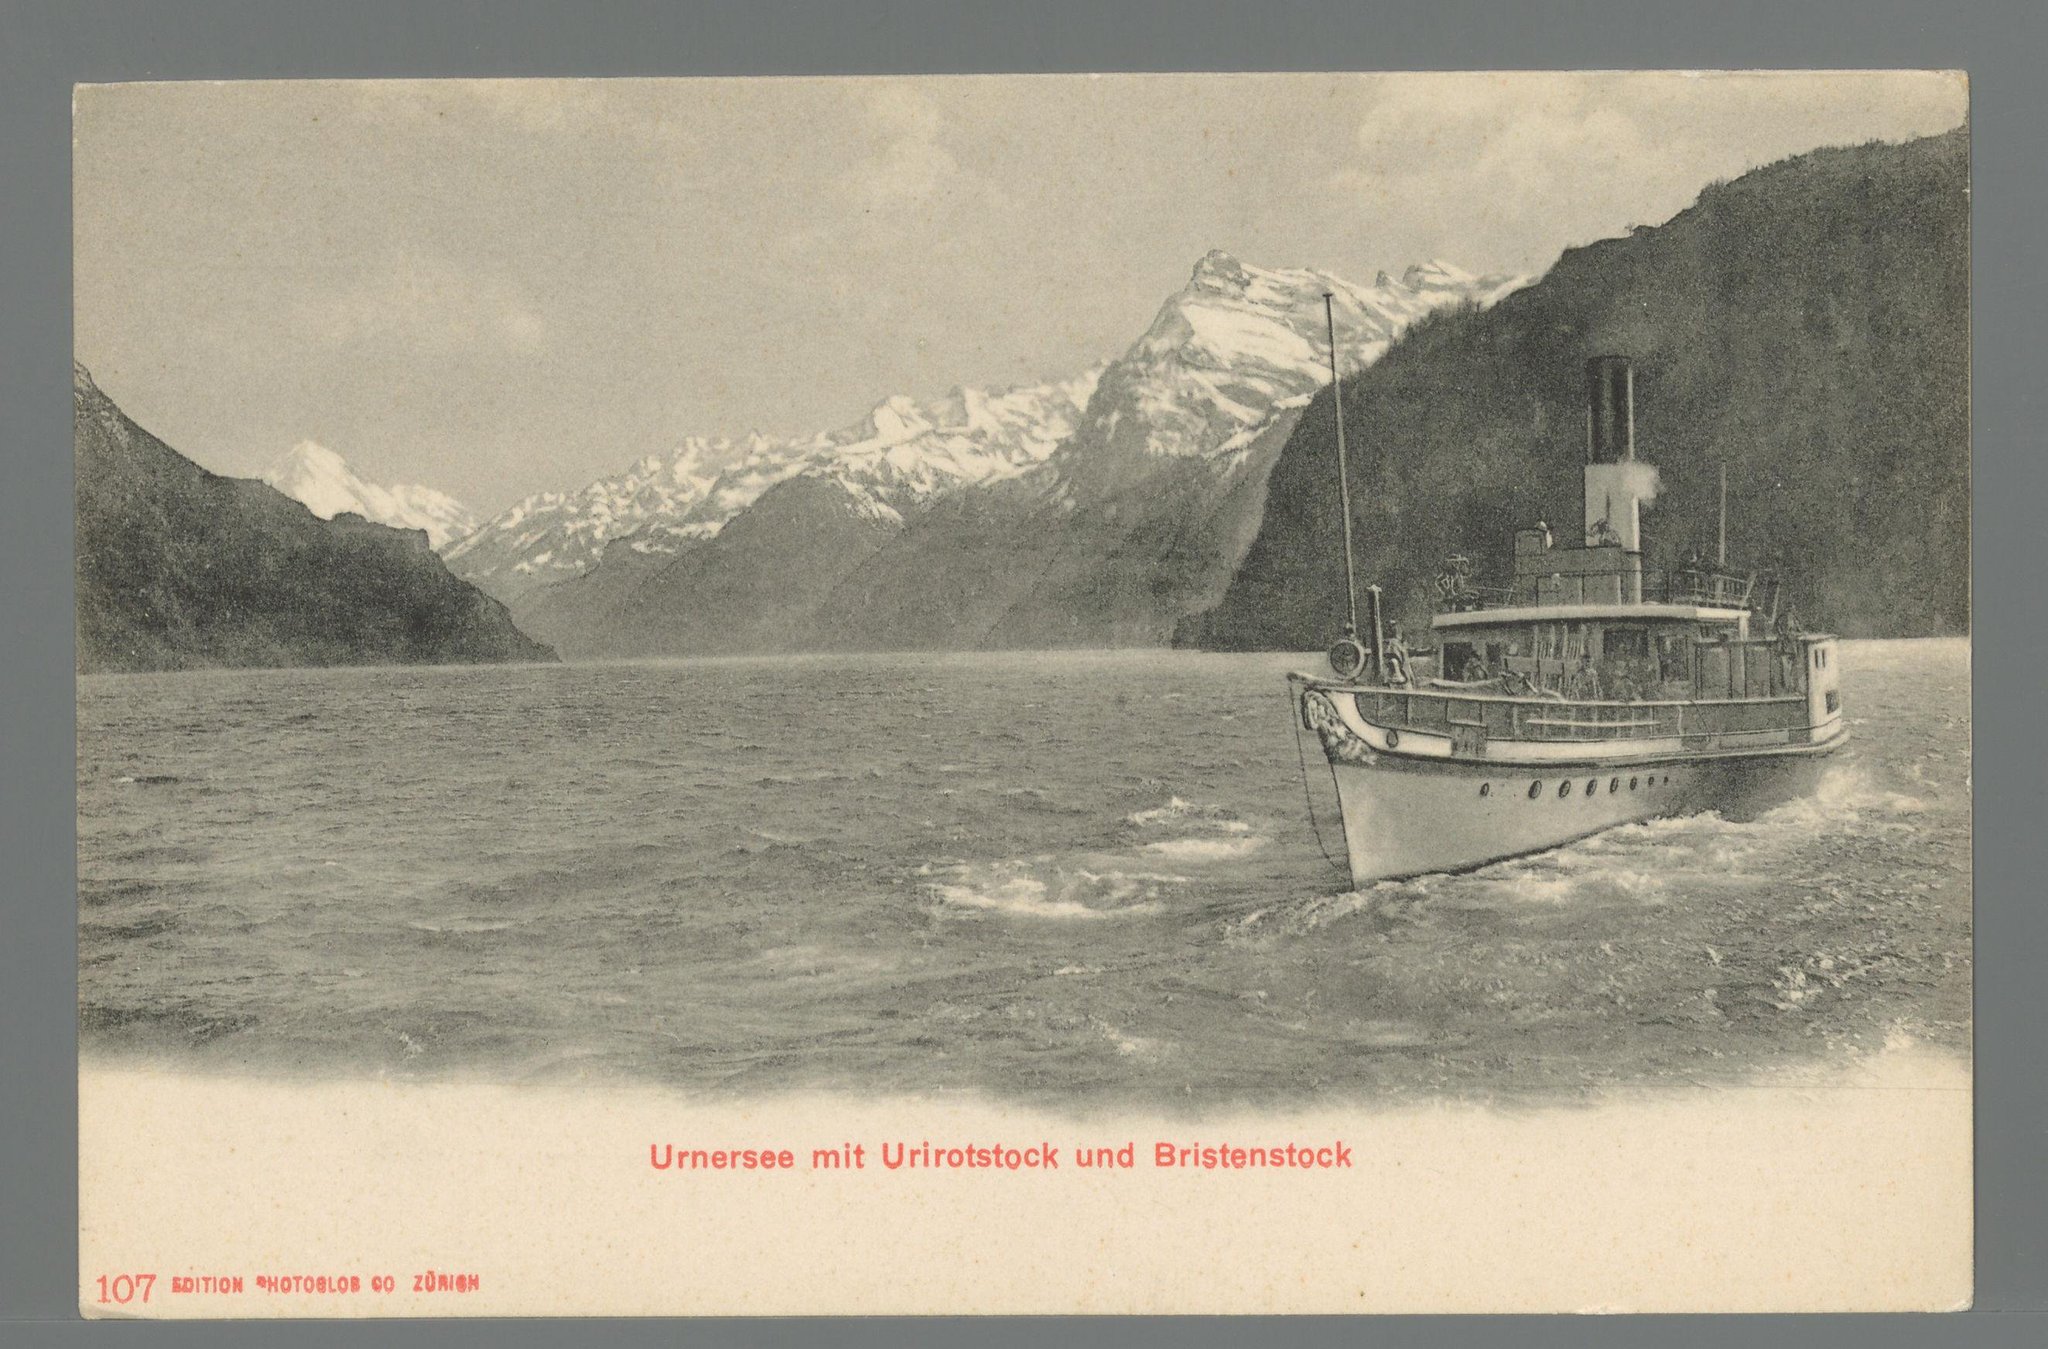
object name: photomechanical print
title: Urnersee mit Urirotstock un Bristenstock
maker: Anonymous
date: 1903-1904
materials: cardboard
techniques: photograph, writing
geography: urnersee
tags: ships (in general), lake, mountain-range, snow peaks